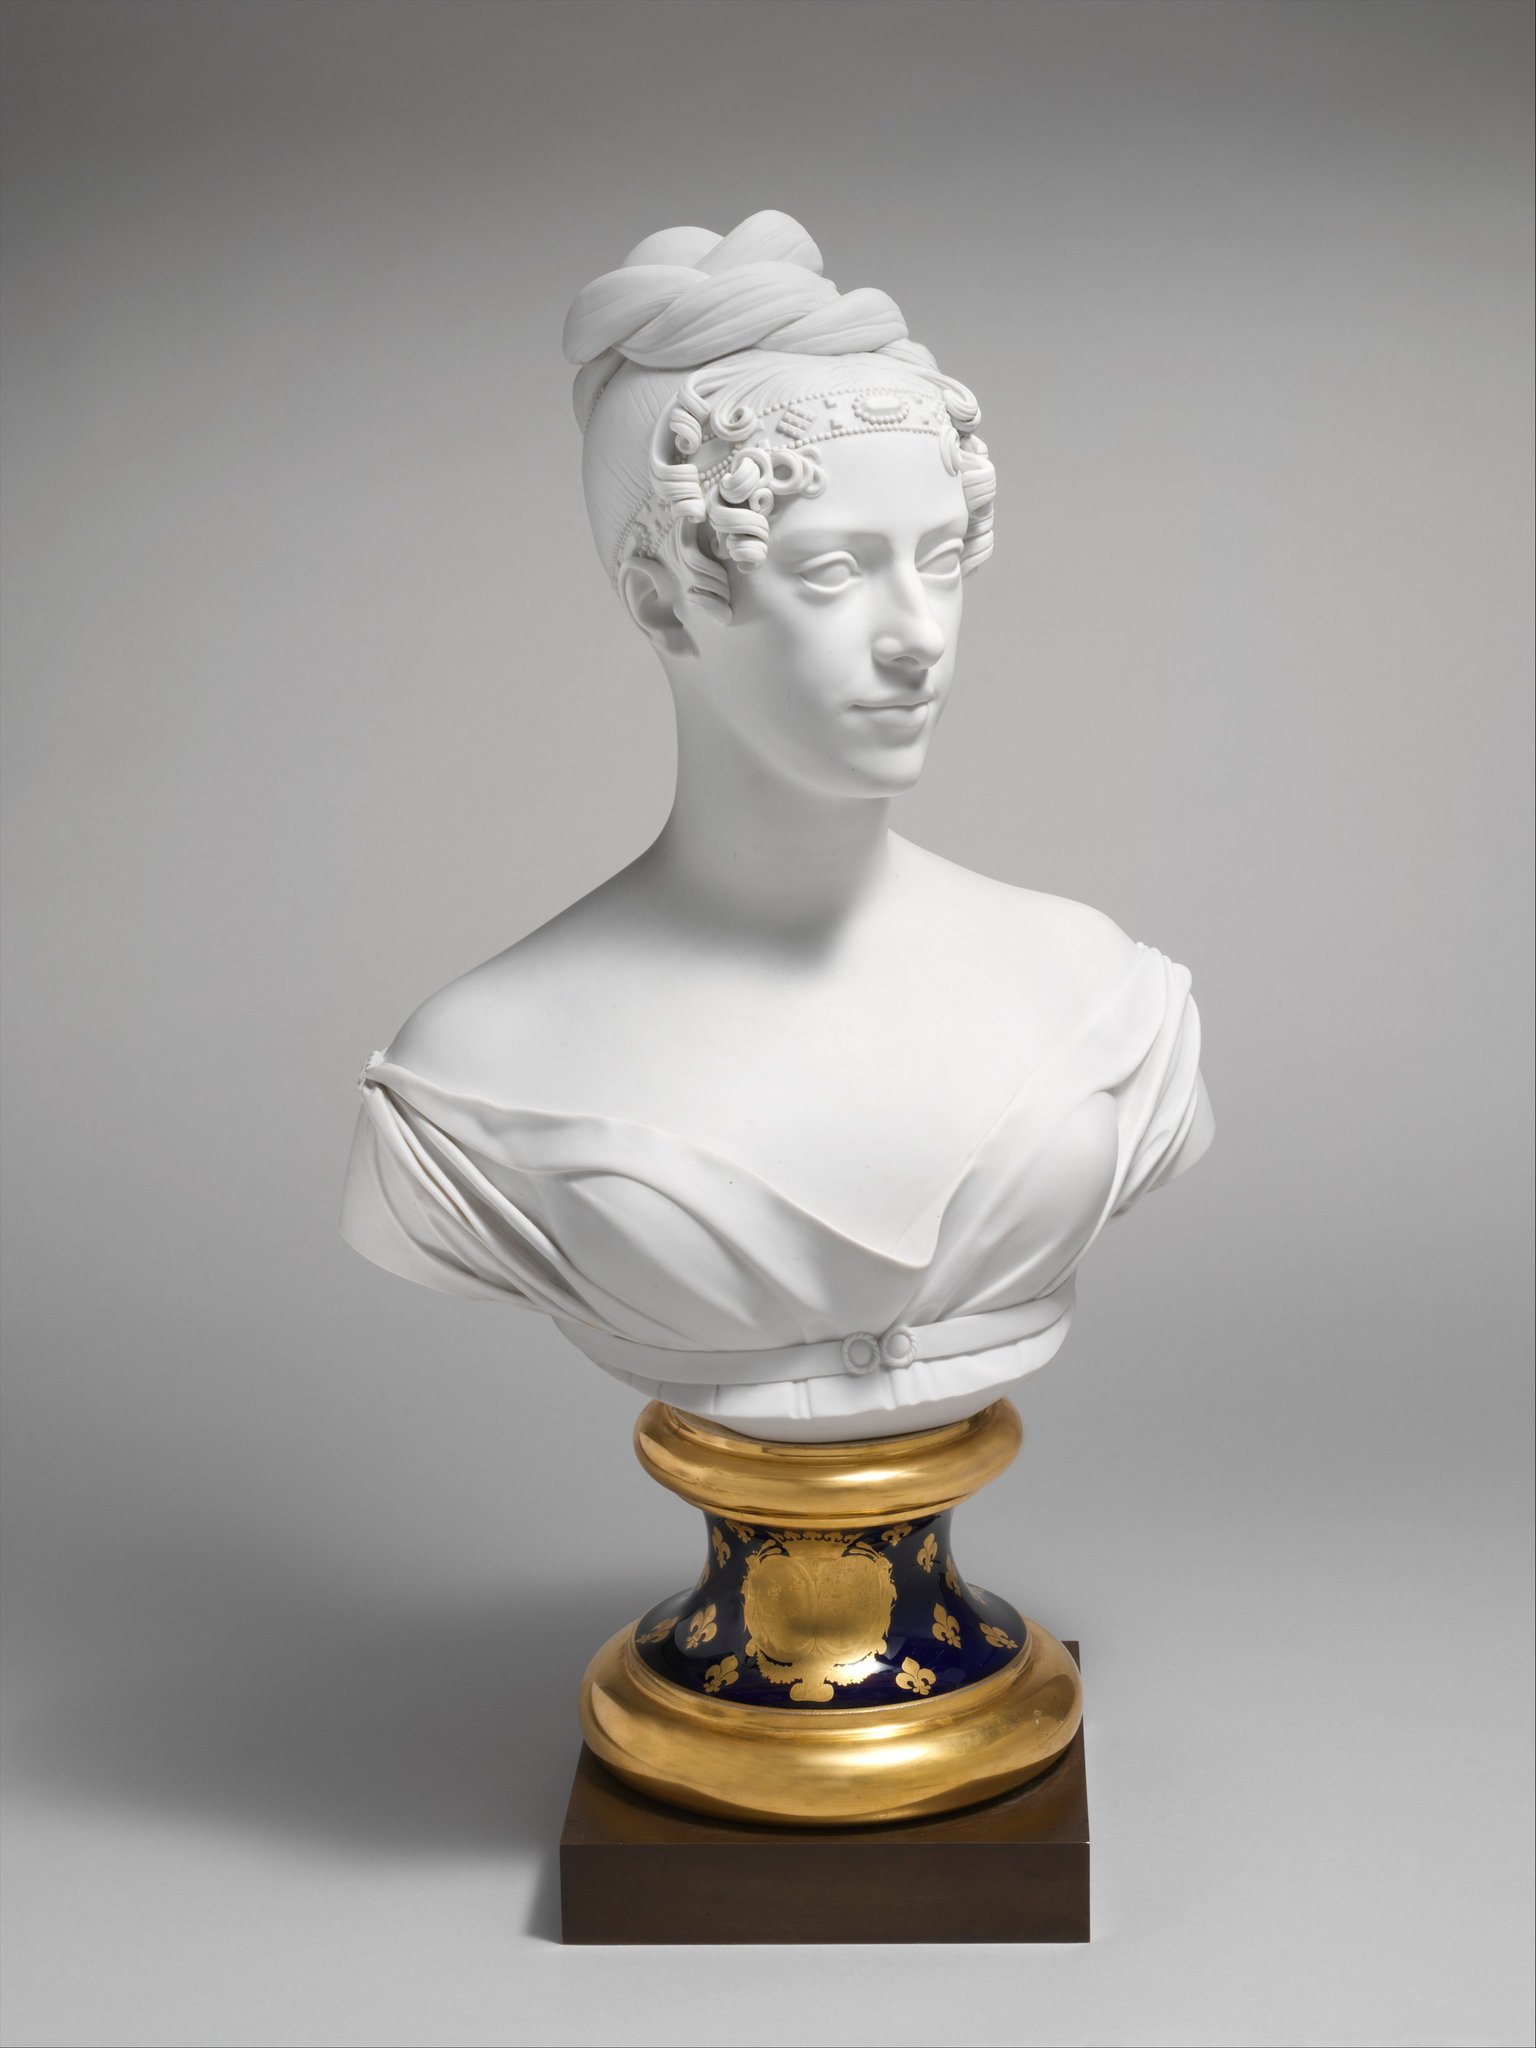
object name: bust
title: The duchesse de Berry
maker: denuelle manufactory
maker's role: manufactory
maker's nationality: french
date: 1820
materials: biscuit, bronze, paste, porcelain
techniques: glazing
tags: women